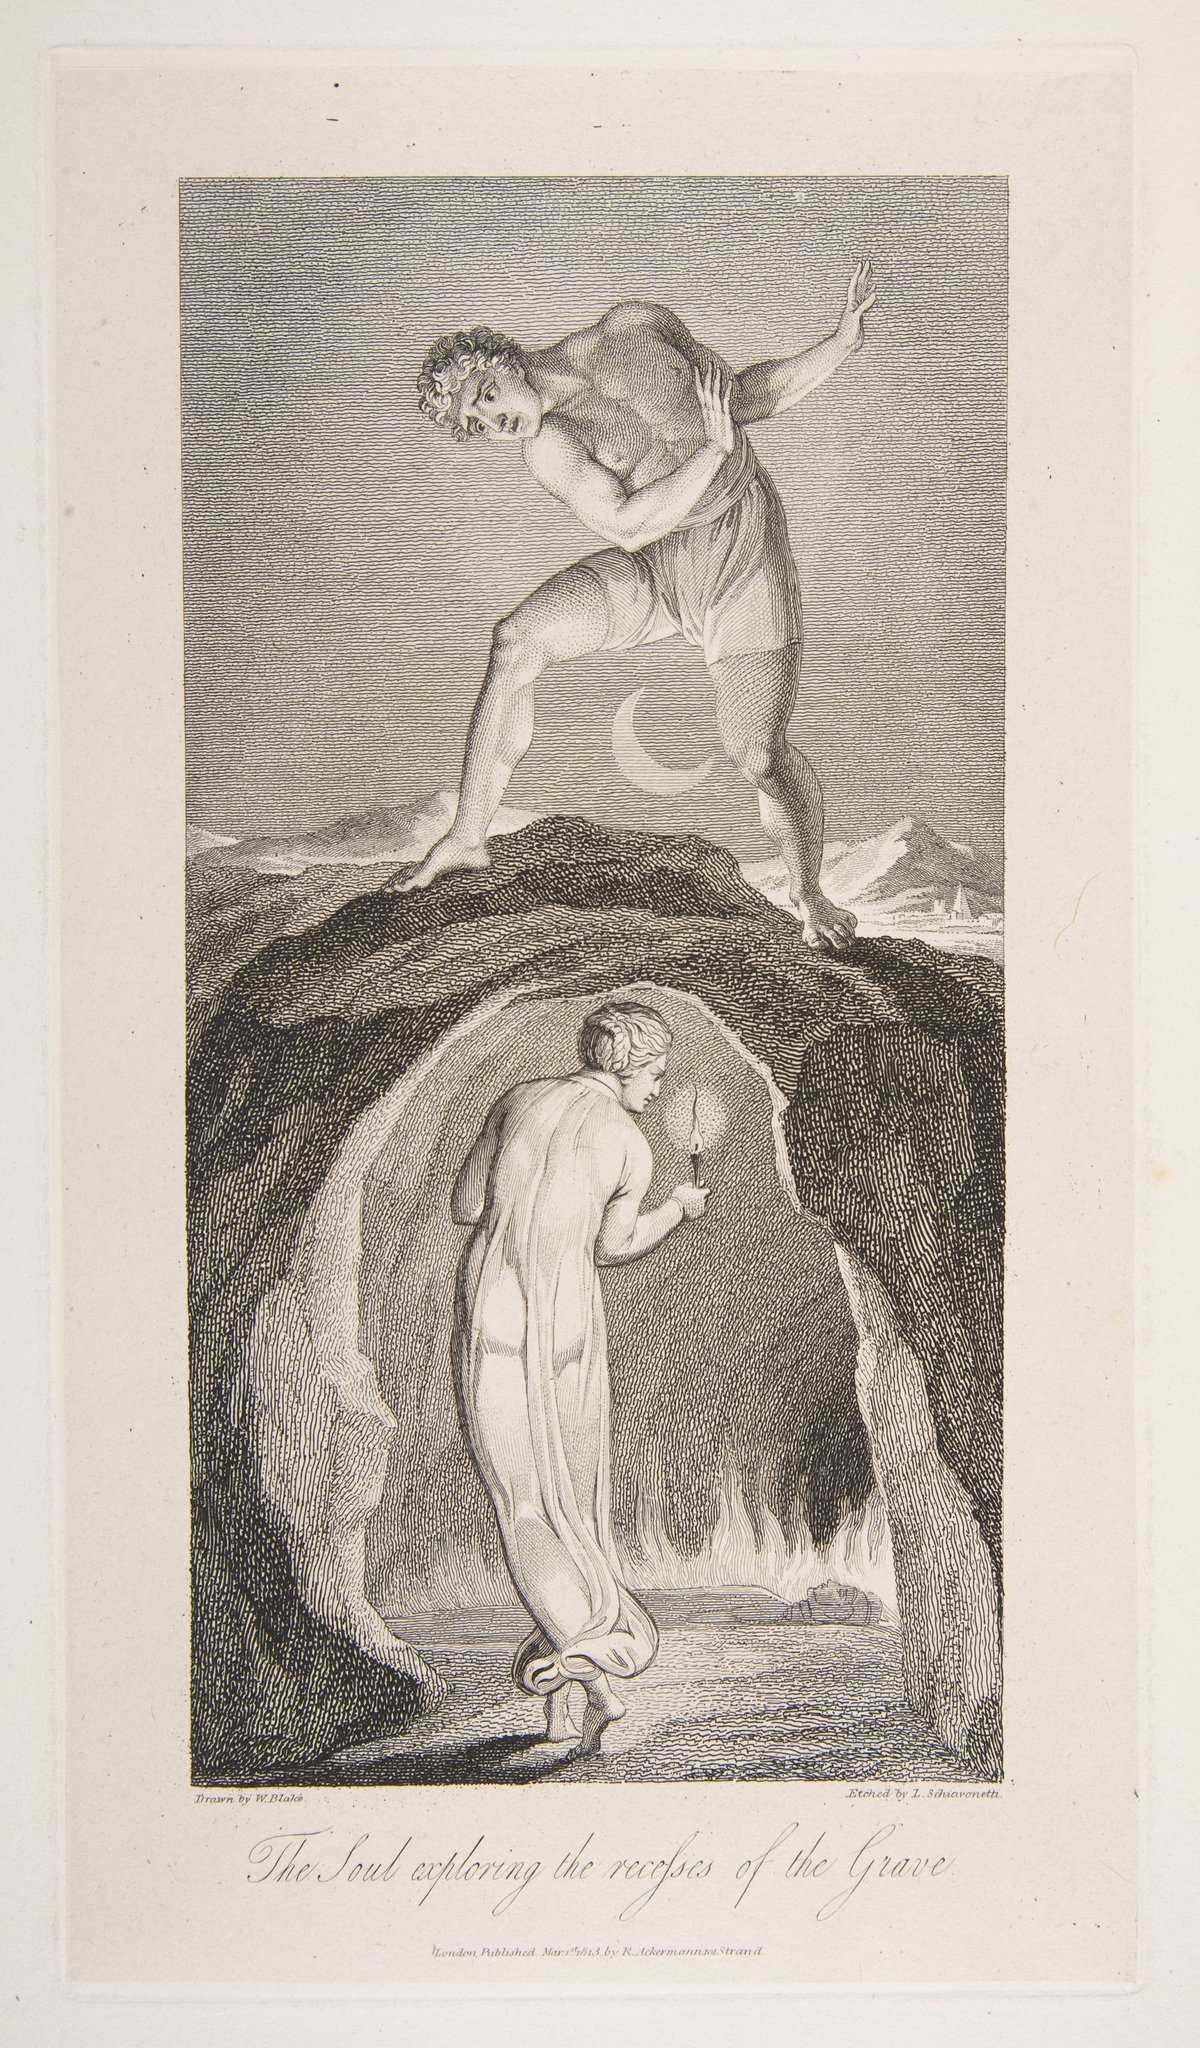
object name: print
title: The Soul Exploring the Recesses of the Grave, from "The Grave," a Poem by Robert Blair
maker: william blake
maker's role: artist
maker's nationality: british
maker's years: 1757-1827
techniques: engraving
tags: corpses,men,women